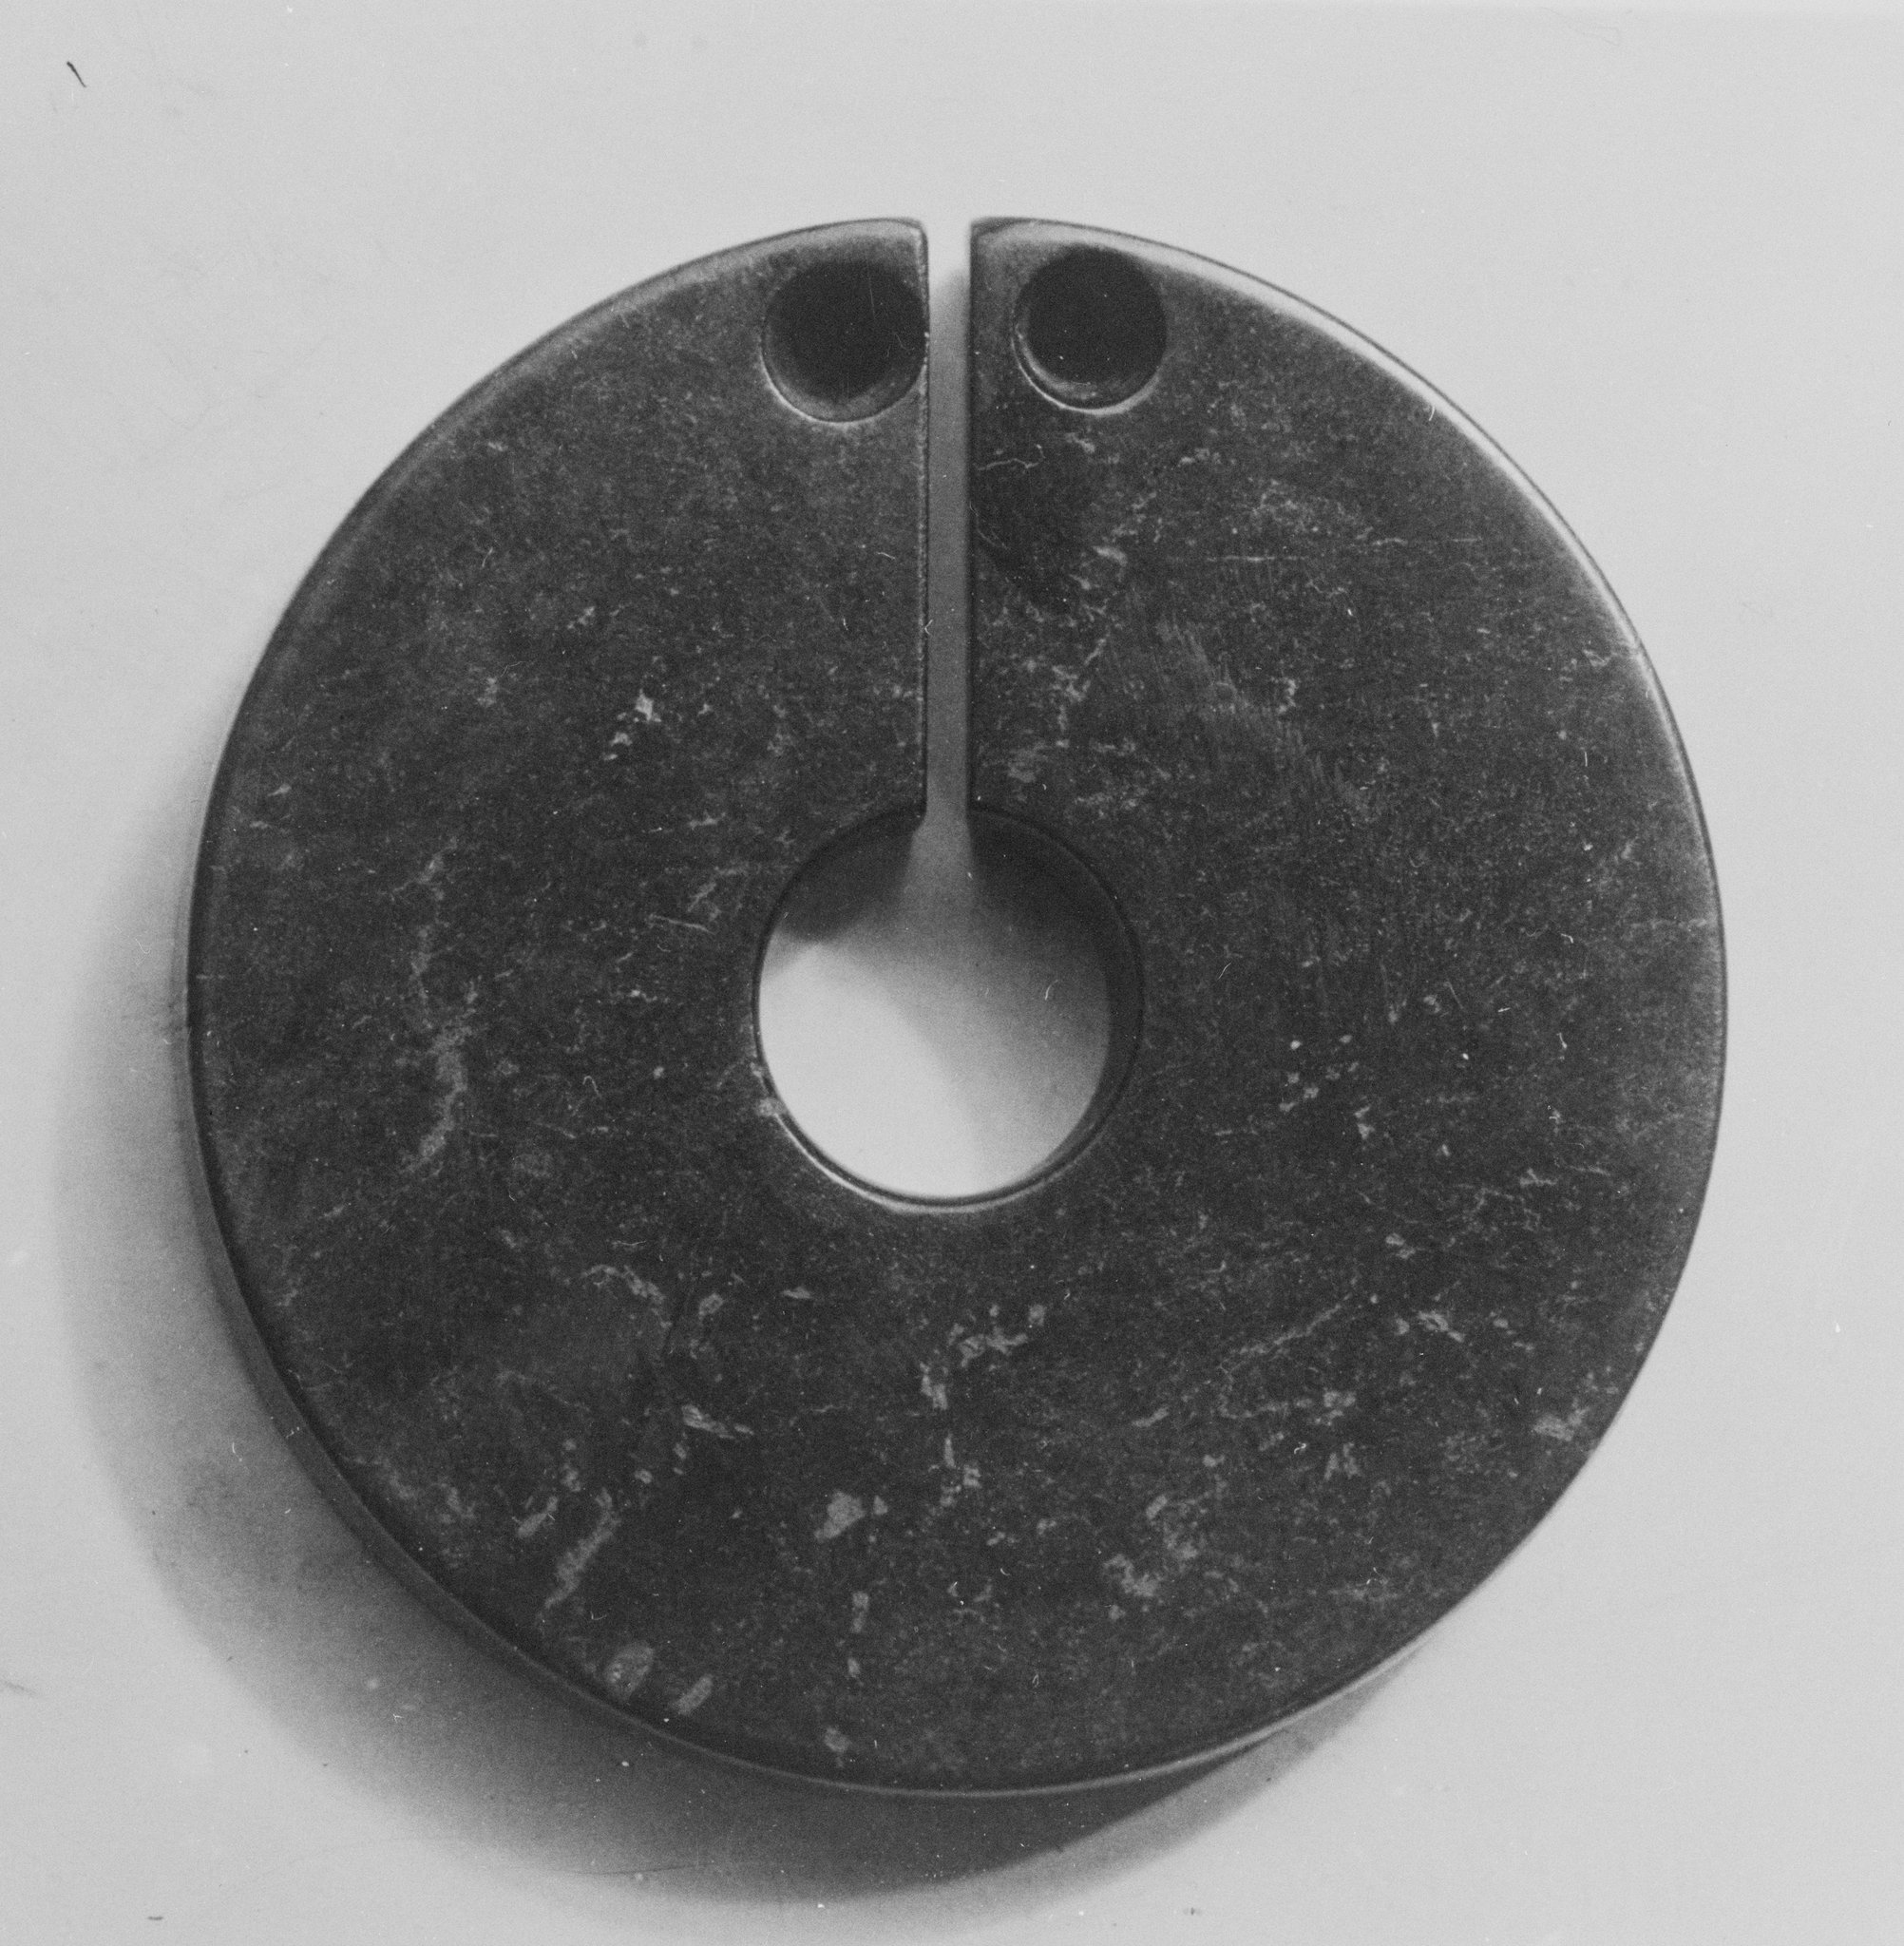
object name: disk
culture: chinese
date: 206 BCE-220 CE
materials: jade